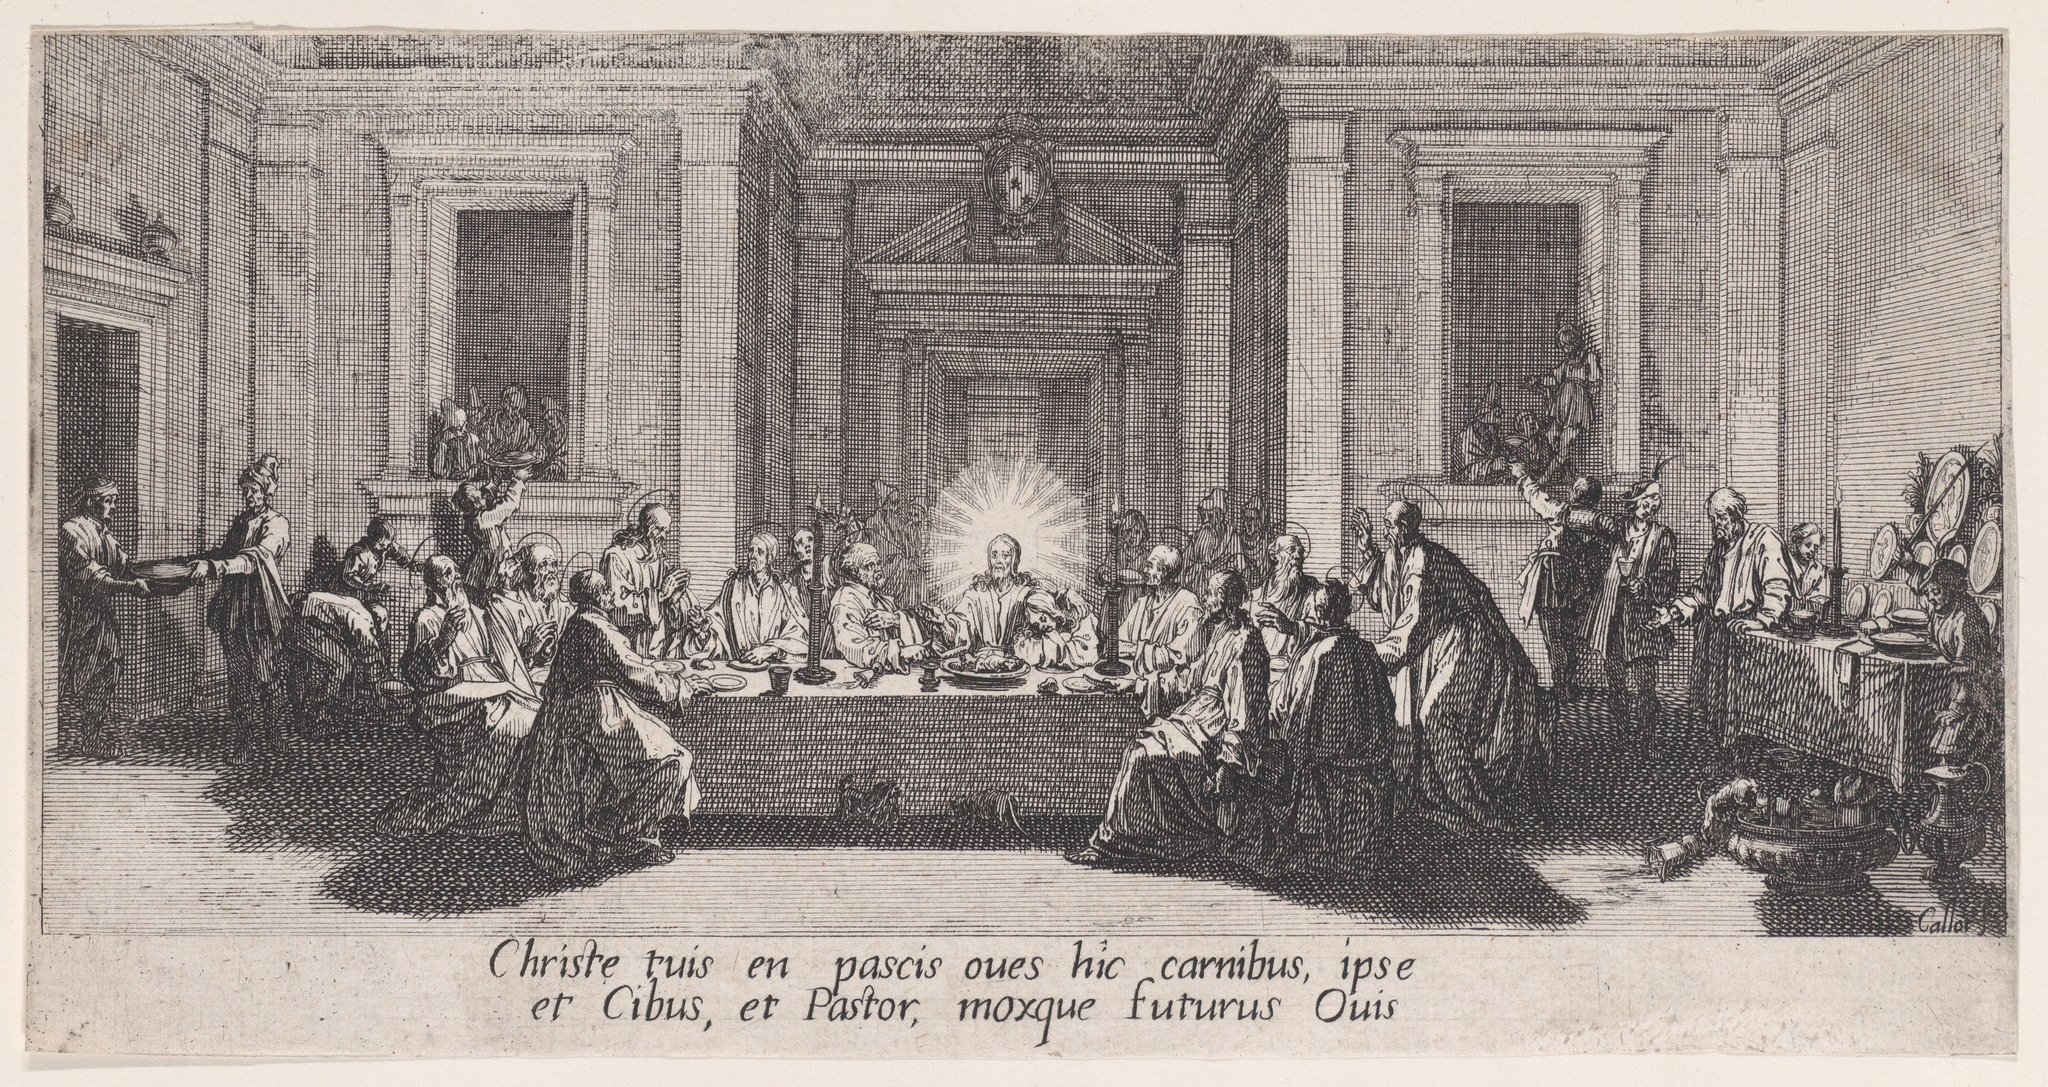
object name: print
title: La Cêne (The Last Supper), from "La Grande Passion" (The Large Passion)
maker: jacques callot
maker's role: artist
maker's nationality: french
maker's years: 1592-1635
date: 1619-1624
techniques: engraving, etching